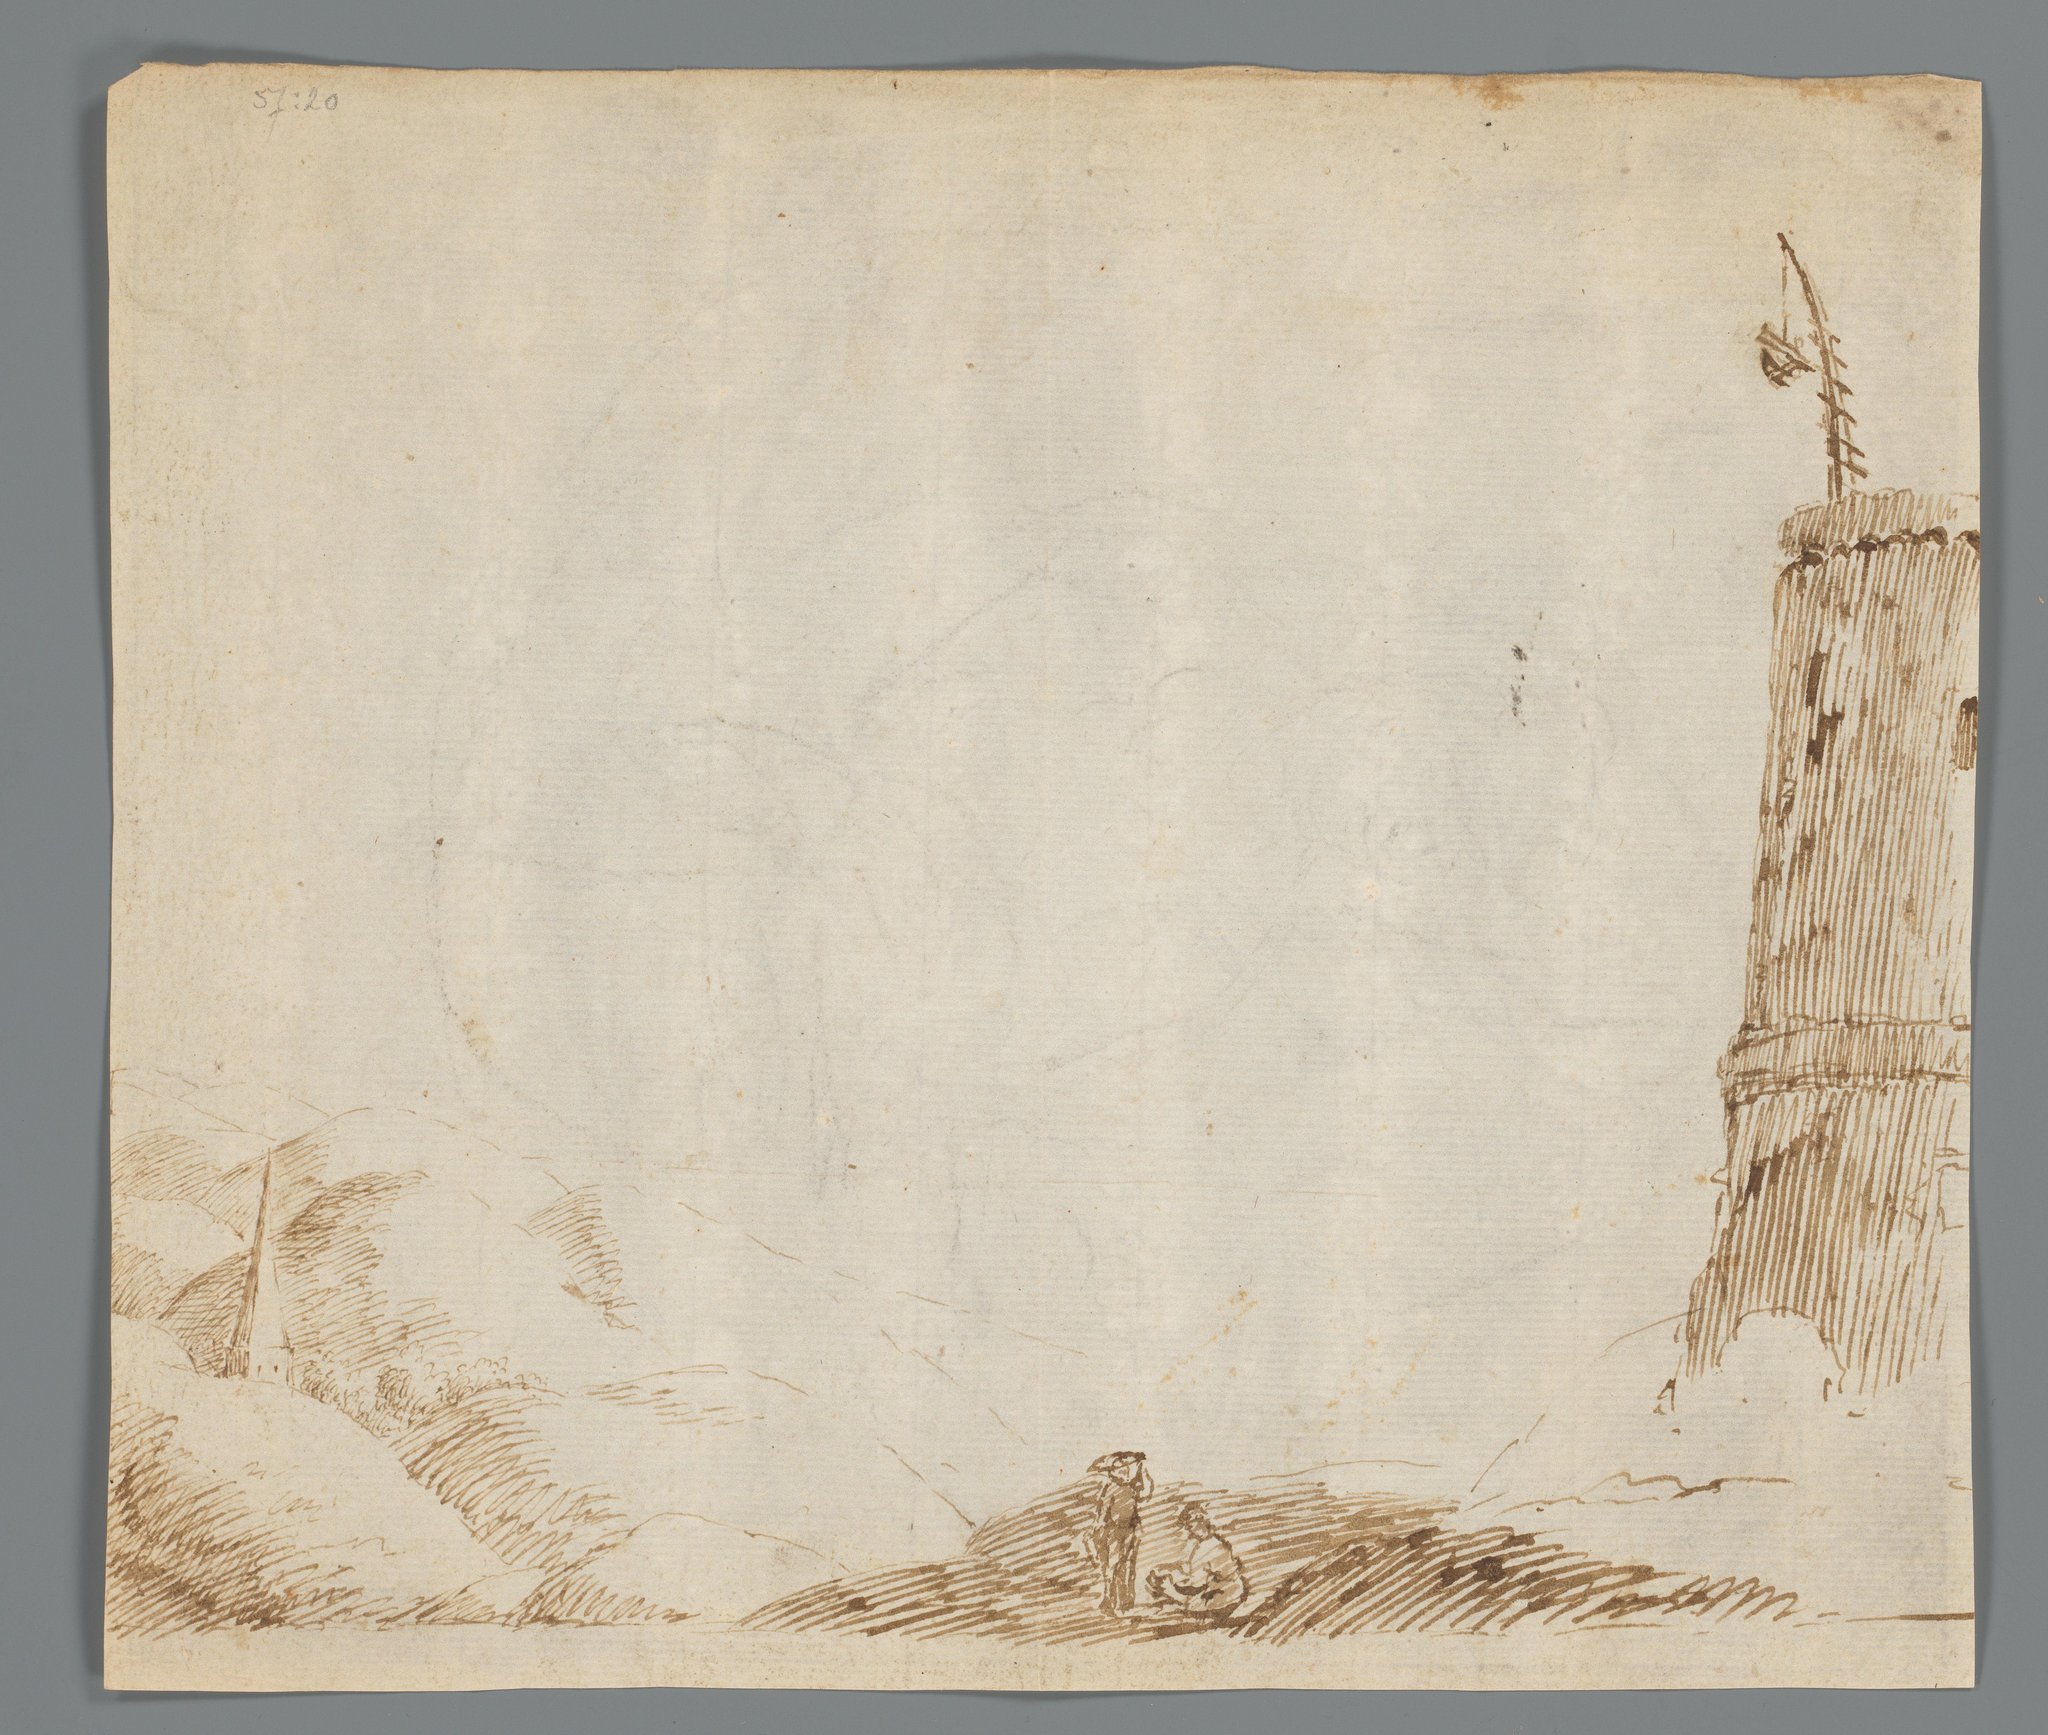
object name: drawing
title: Vergezicht met twee figuren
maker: matthijs balen (1684-1766)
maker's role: draughtsman, painter, print maker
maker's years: 1684-1766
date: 1694-1766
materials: paper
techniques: pen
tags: city-view, and landscape with man-made constructions